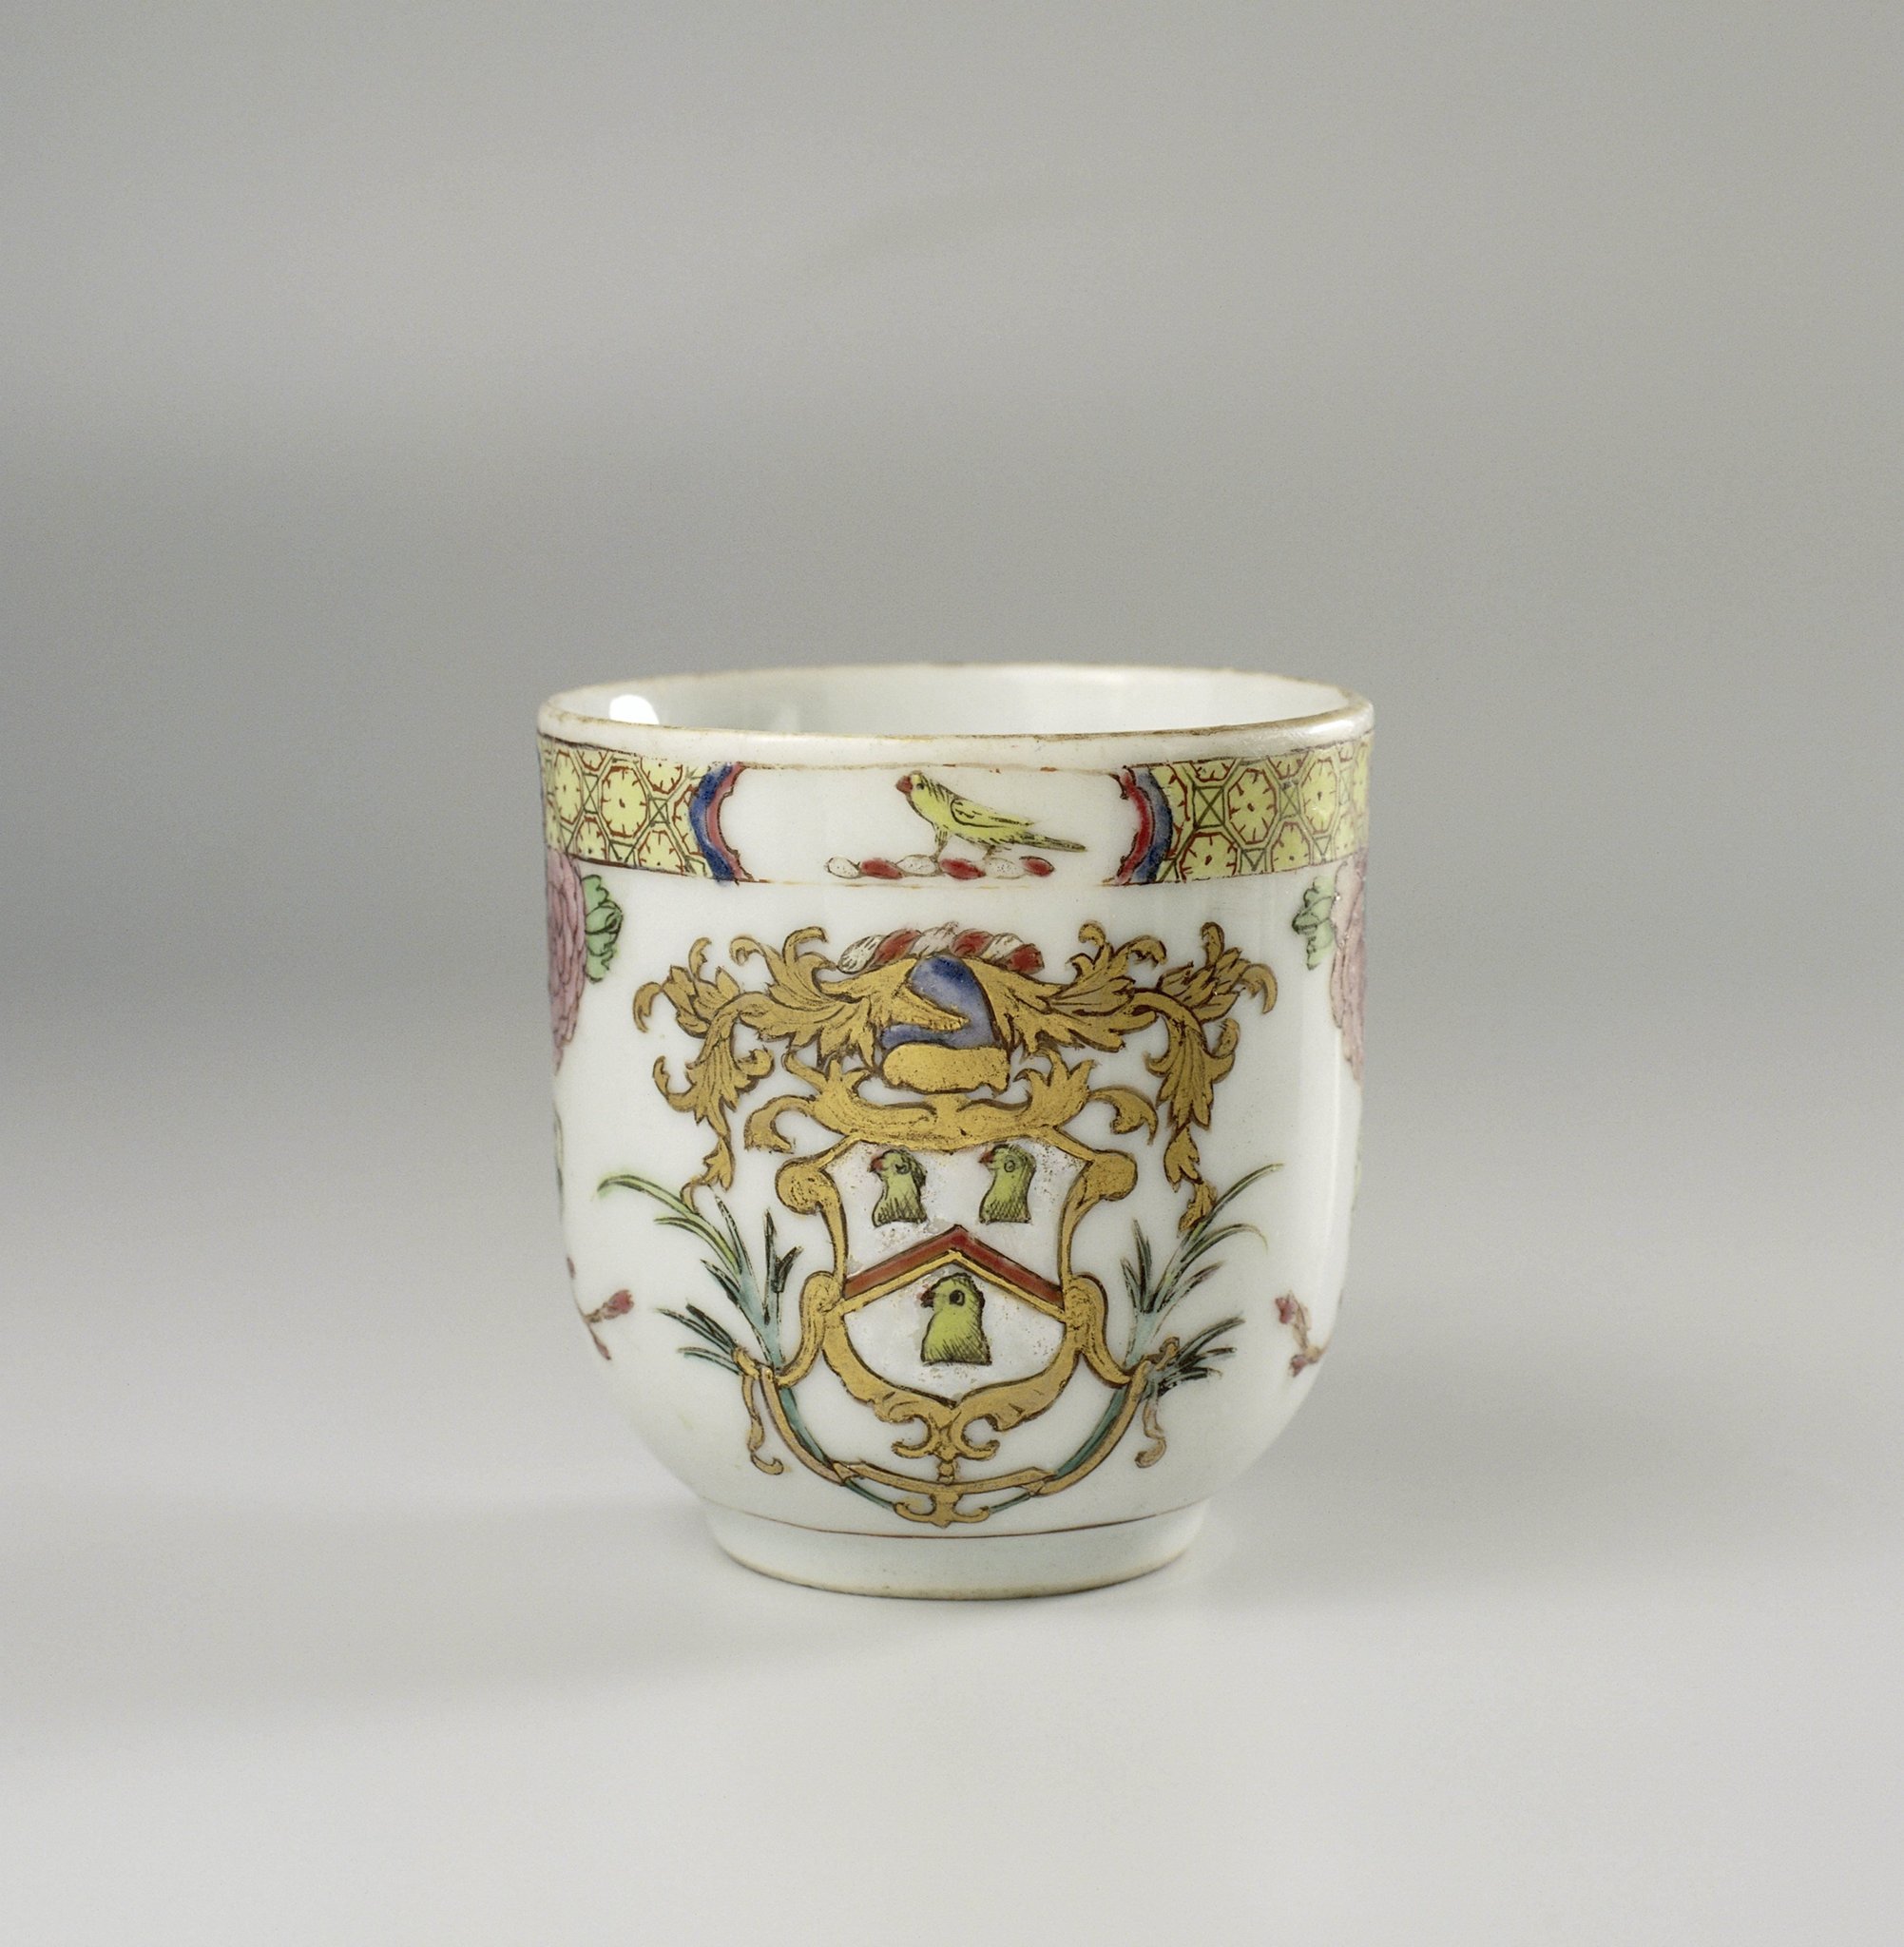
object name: oorkop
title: Cup with handle with a coat of arms and peony sprays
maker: Anonymous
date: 1725-1749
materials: glaze, gold, paint, porcelain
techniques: firing, gilding, turning, vitrification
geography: china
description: Oorkop van porselein met c-vormig oor, beschilderd op het glazuur in blauw, rood, roze, groen, geel, zwart en goud. Op het plat een ongeïdentificeerd familiewapen met drie vogelkoppen op een witte achtergrond met een rood/gouden keper. Het wapen is omgeven door bladranken en palmtakken. Aan weerszijden van het wapen pioentakken. Op de buitenrand een band met servetwerk onderbroken door cartouches met een bloemrank; boven het wapen een cartouche met het helmteken, een vogel. Wapenporselein met emailkleuren.